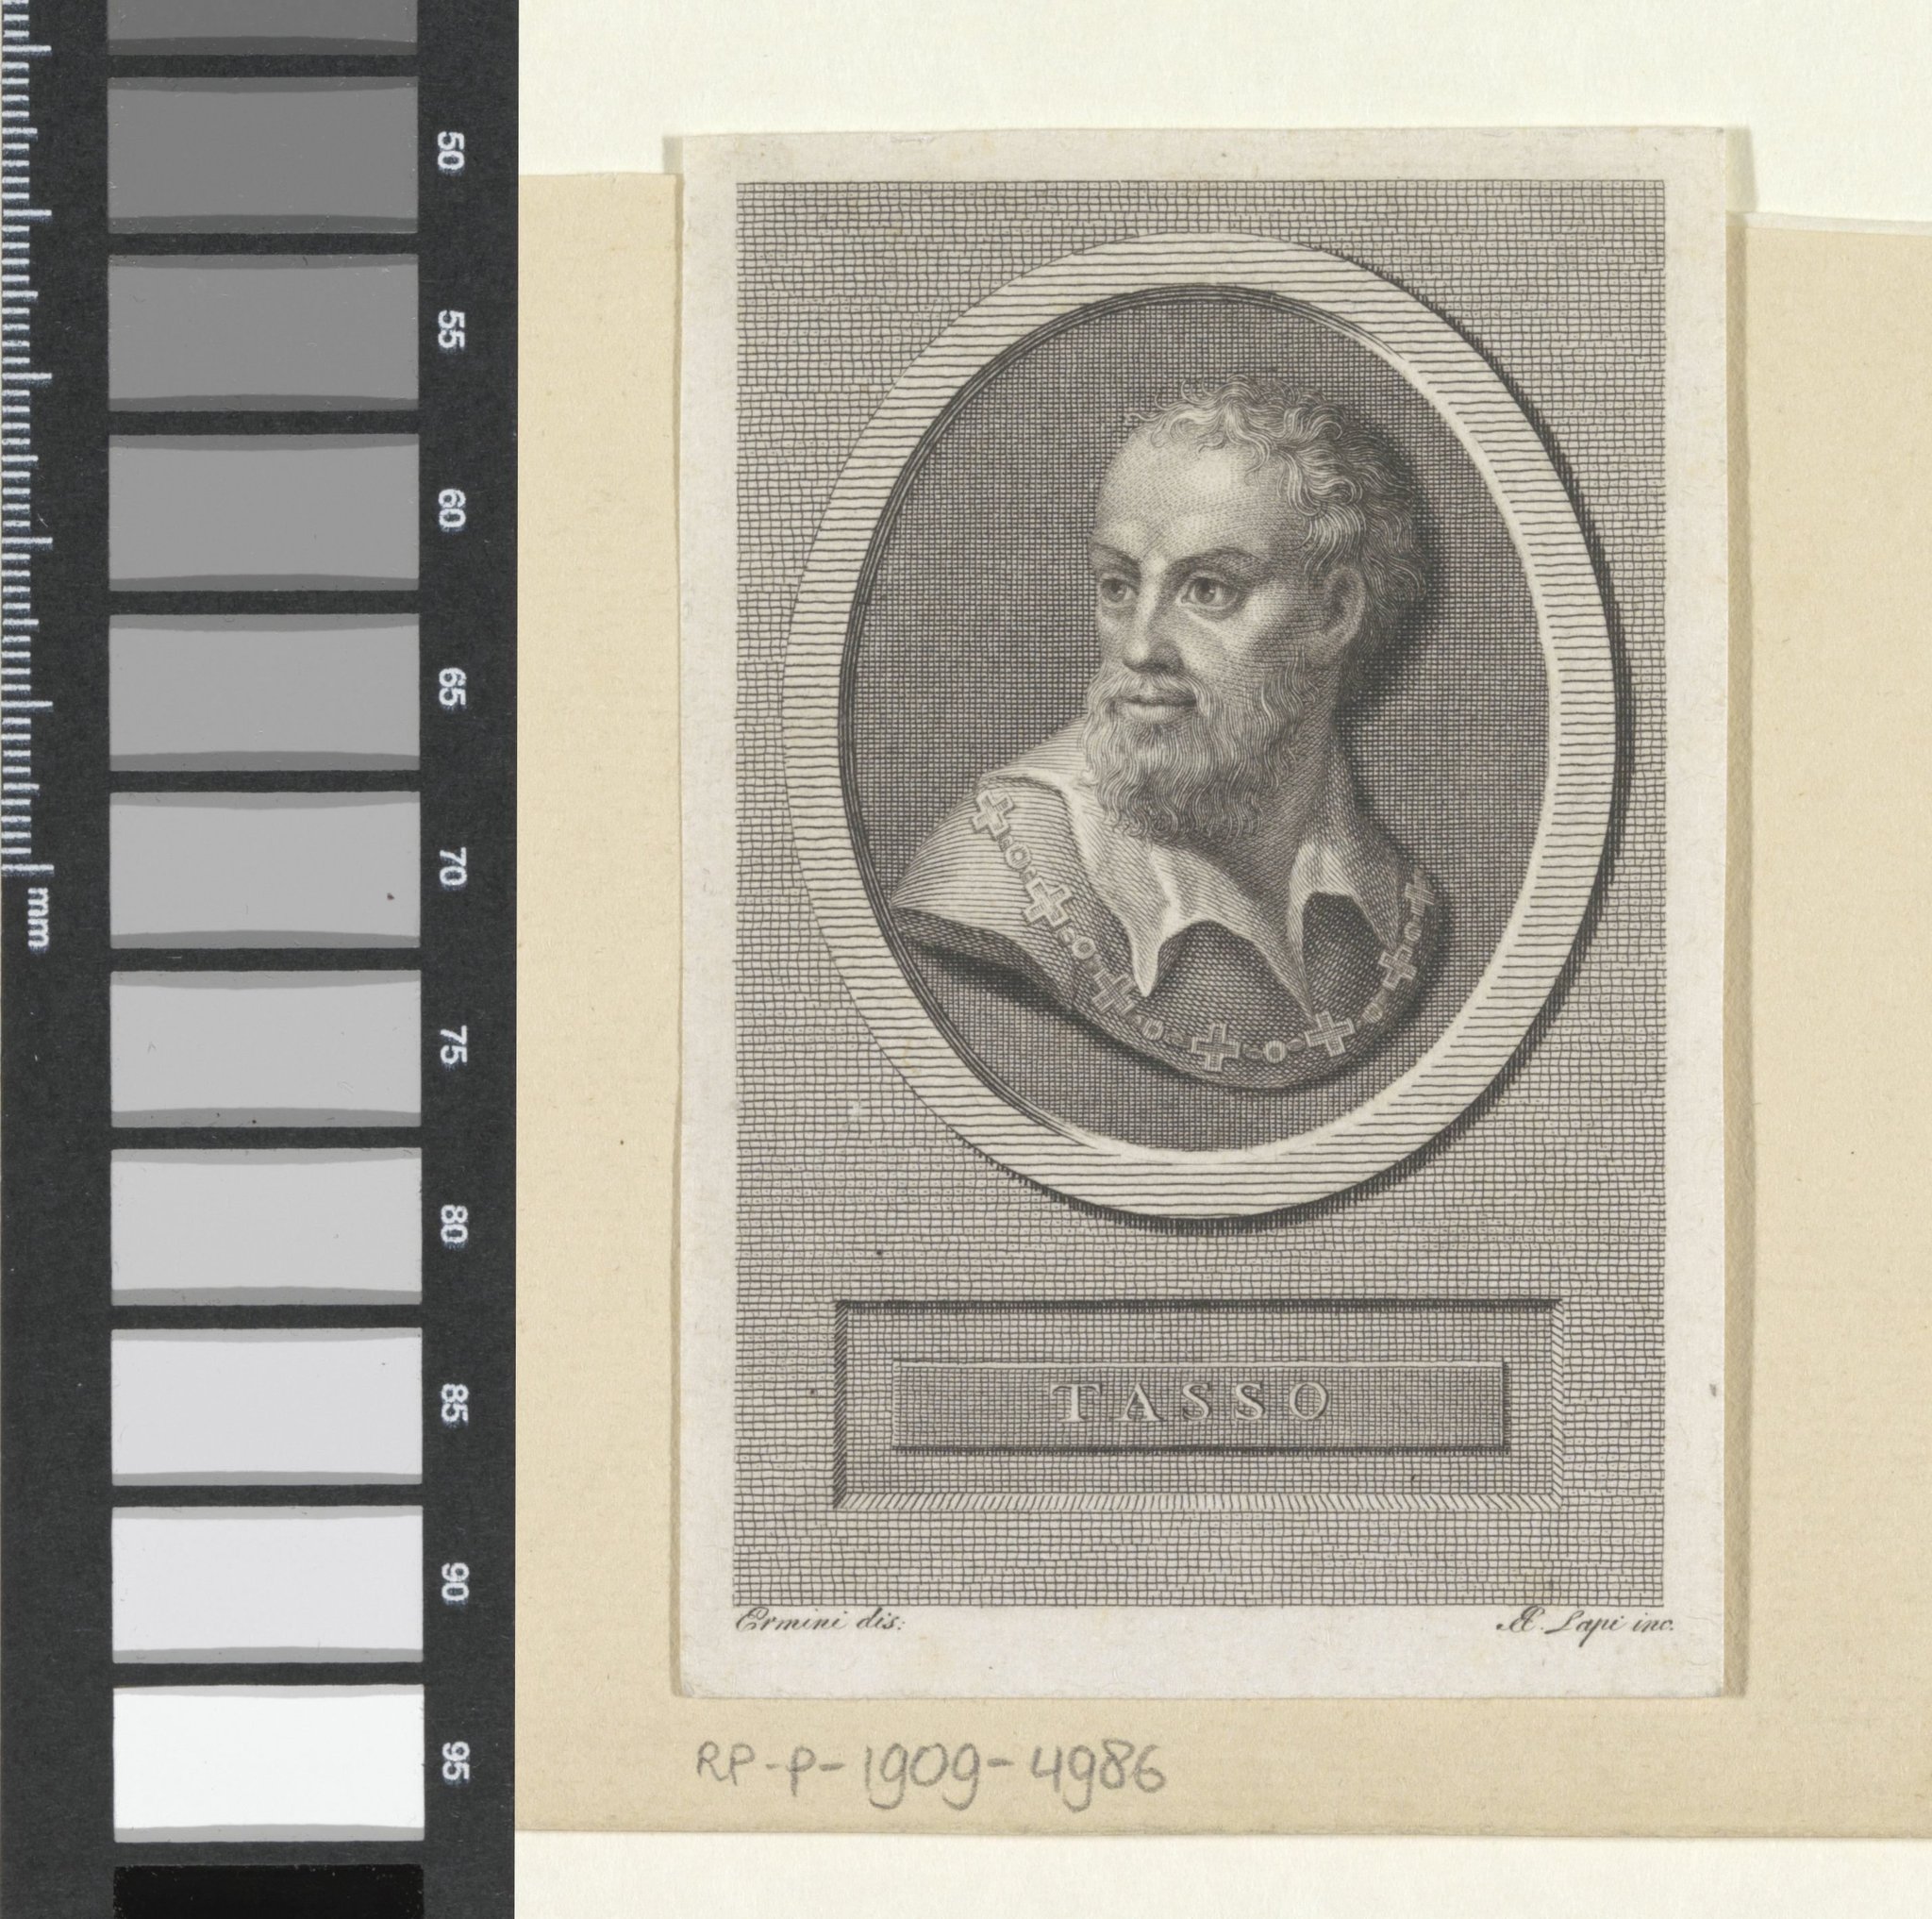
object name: print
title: Portret van dichter Torquato Tasso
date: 1779-1852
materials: paper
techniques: engraving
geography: italy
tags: rome, torquato tasso, historical persons, portrait of a writer, writer, poet, author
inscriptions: collector's mark: Lugt 2228